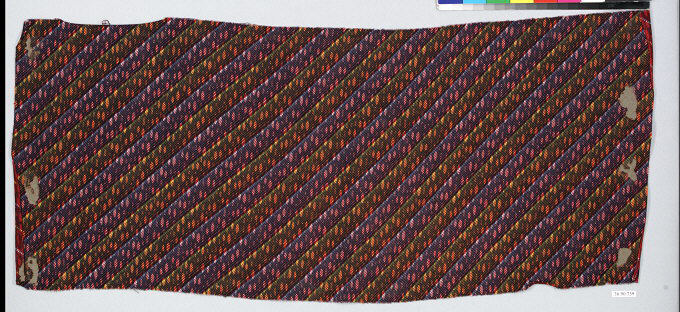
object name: piece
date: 1867-1900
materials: cotton